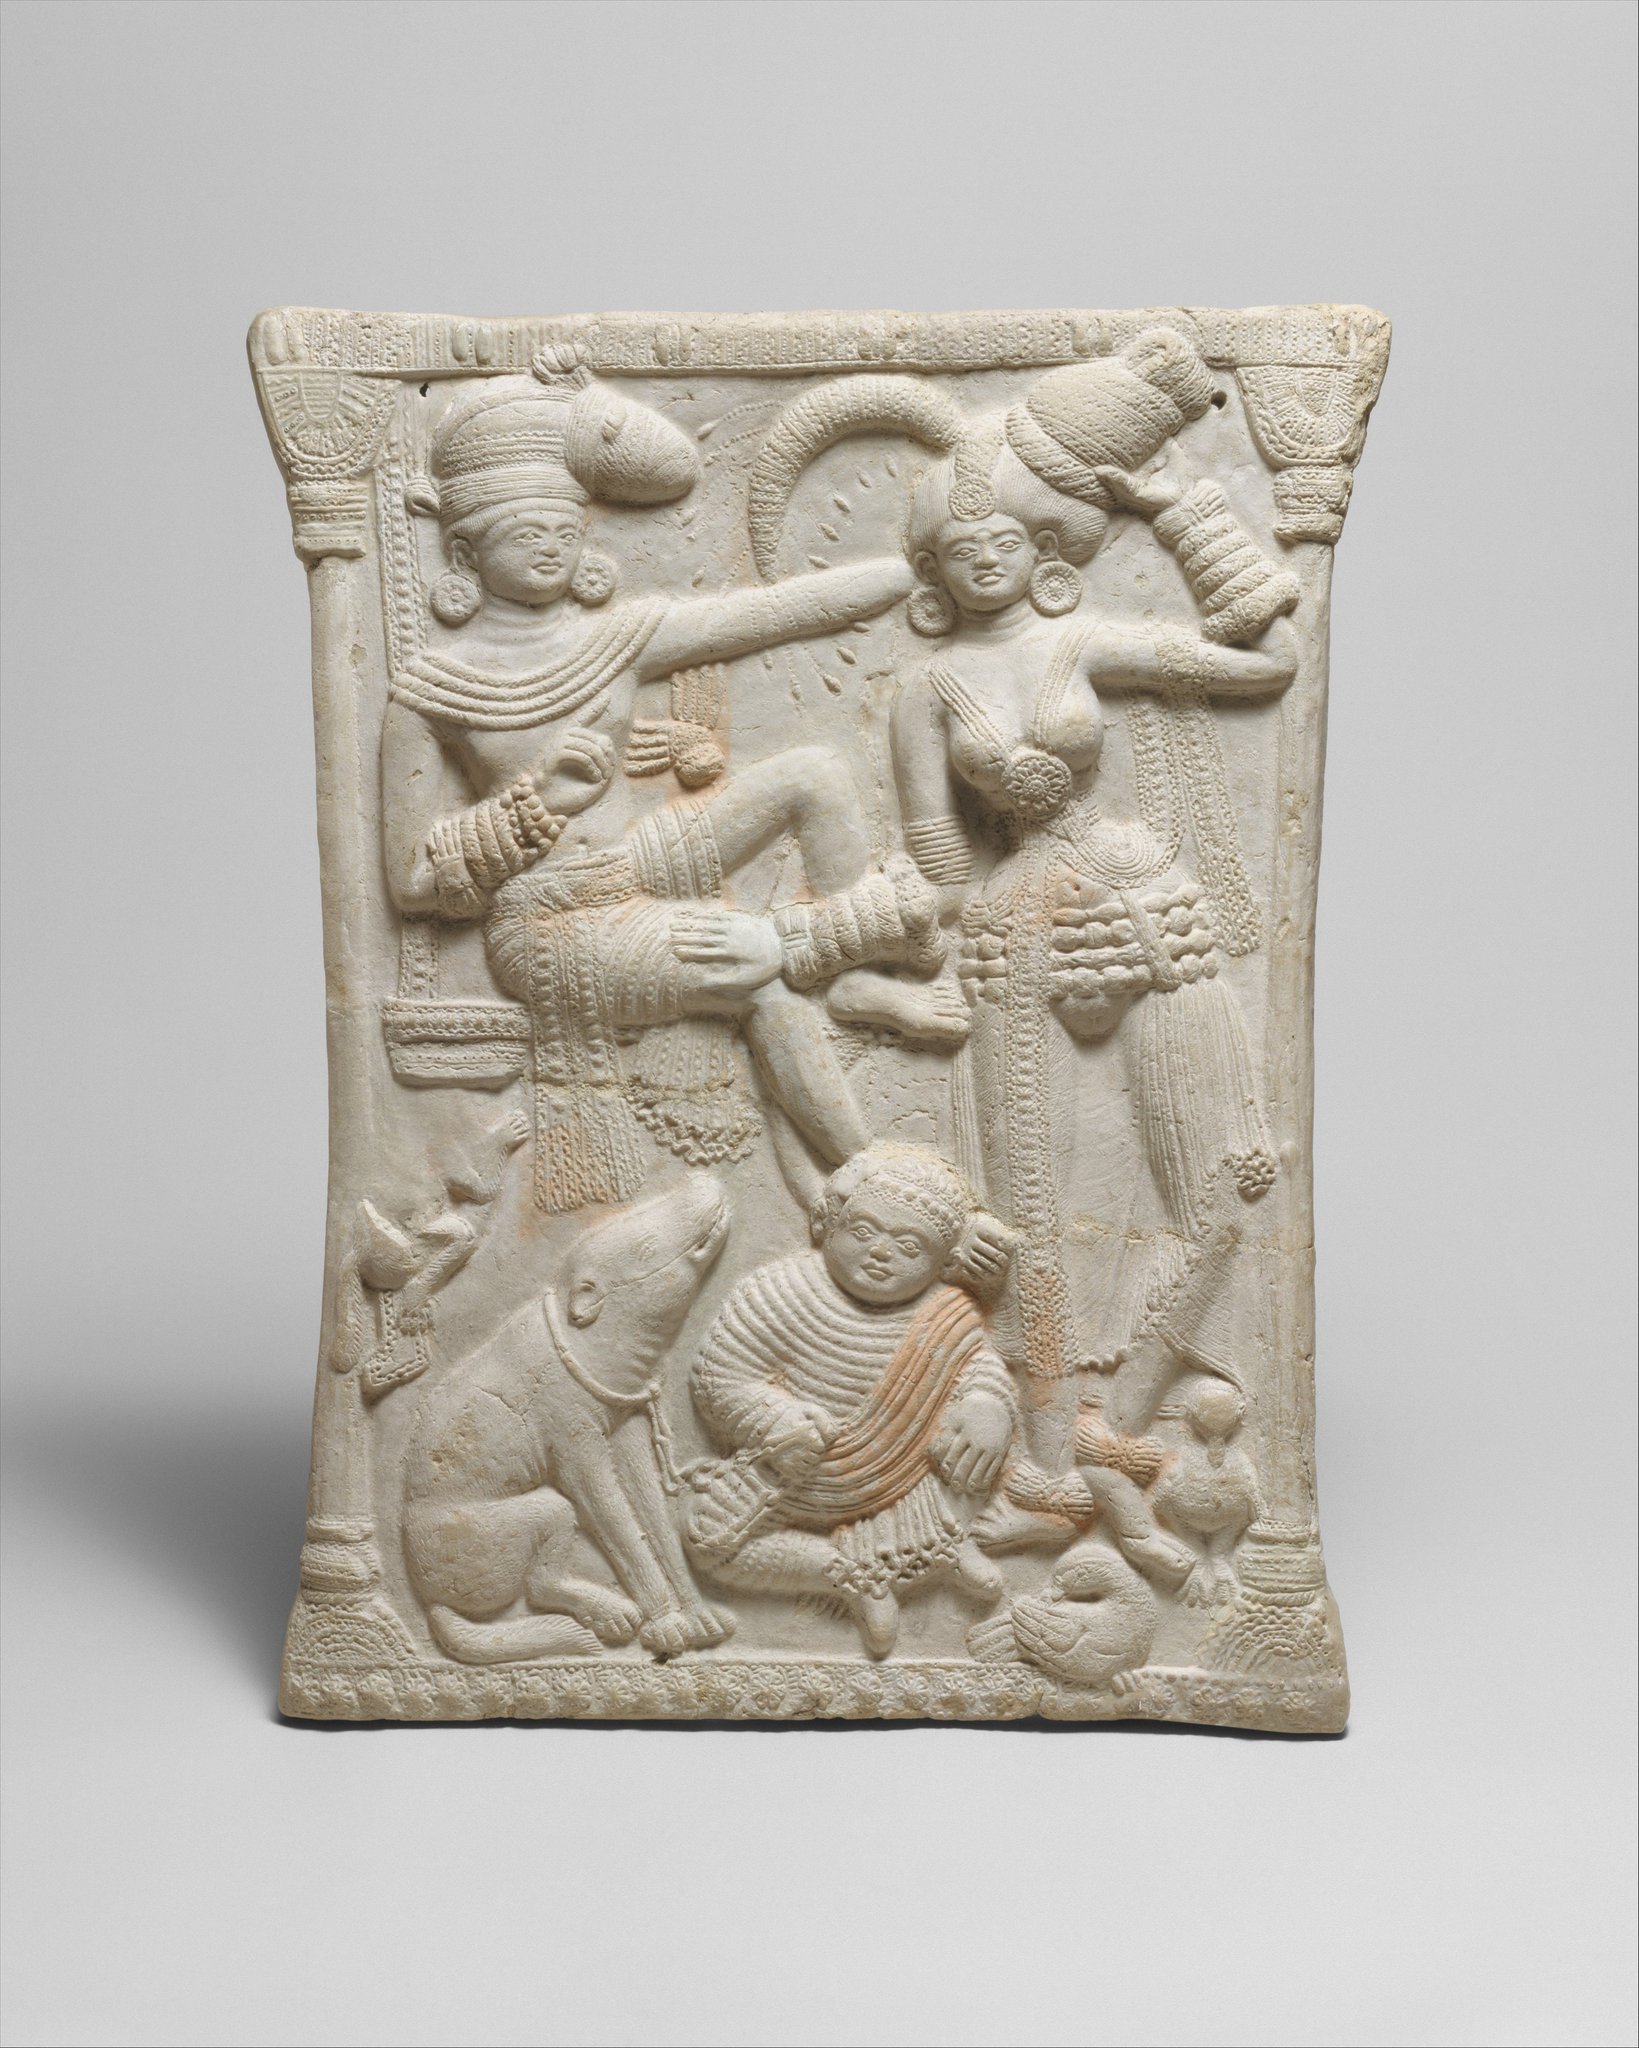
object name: plaque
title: Plaque with a Royal Family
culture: indian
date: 100-1 BCE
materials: terracotta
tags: ducks,boys,men,women,dogs,family